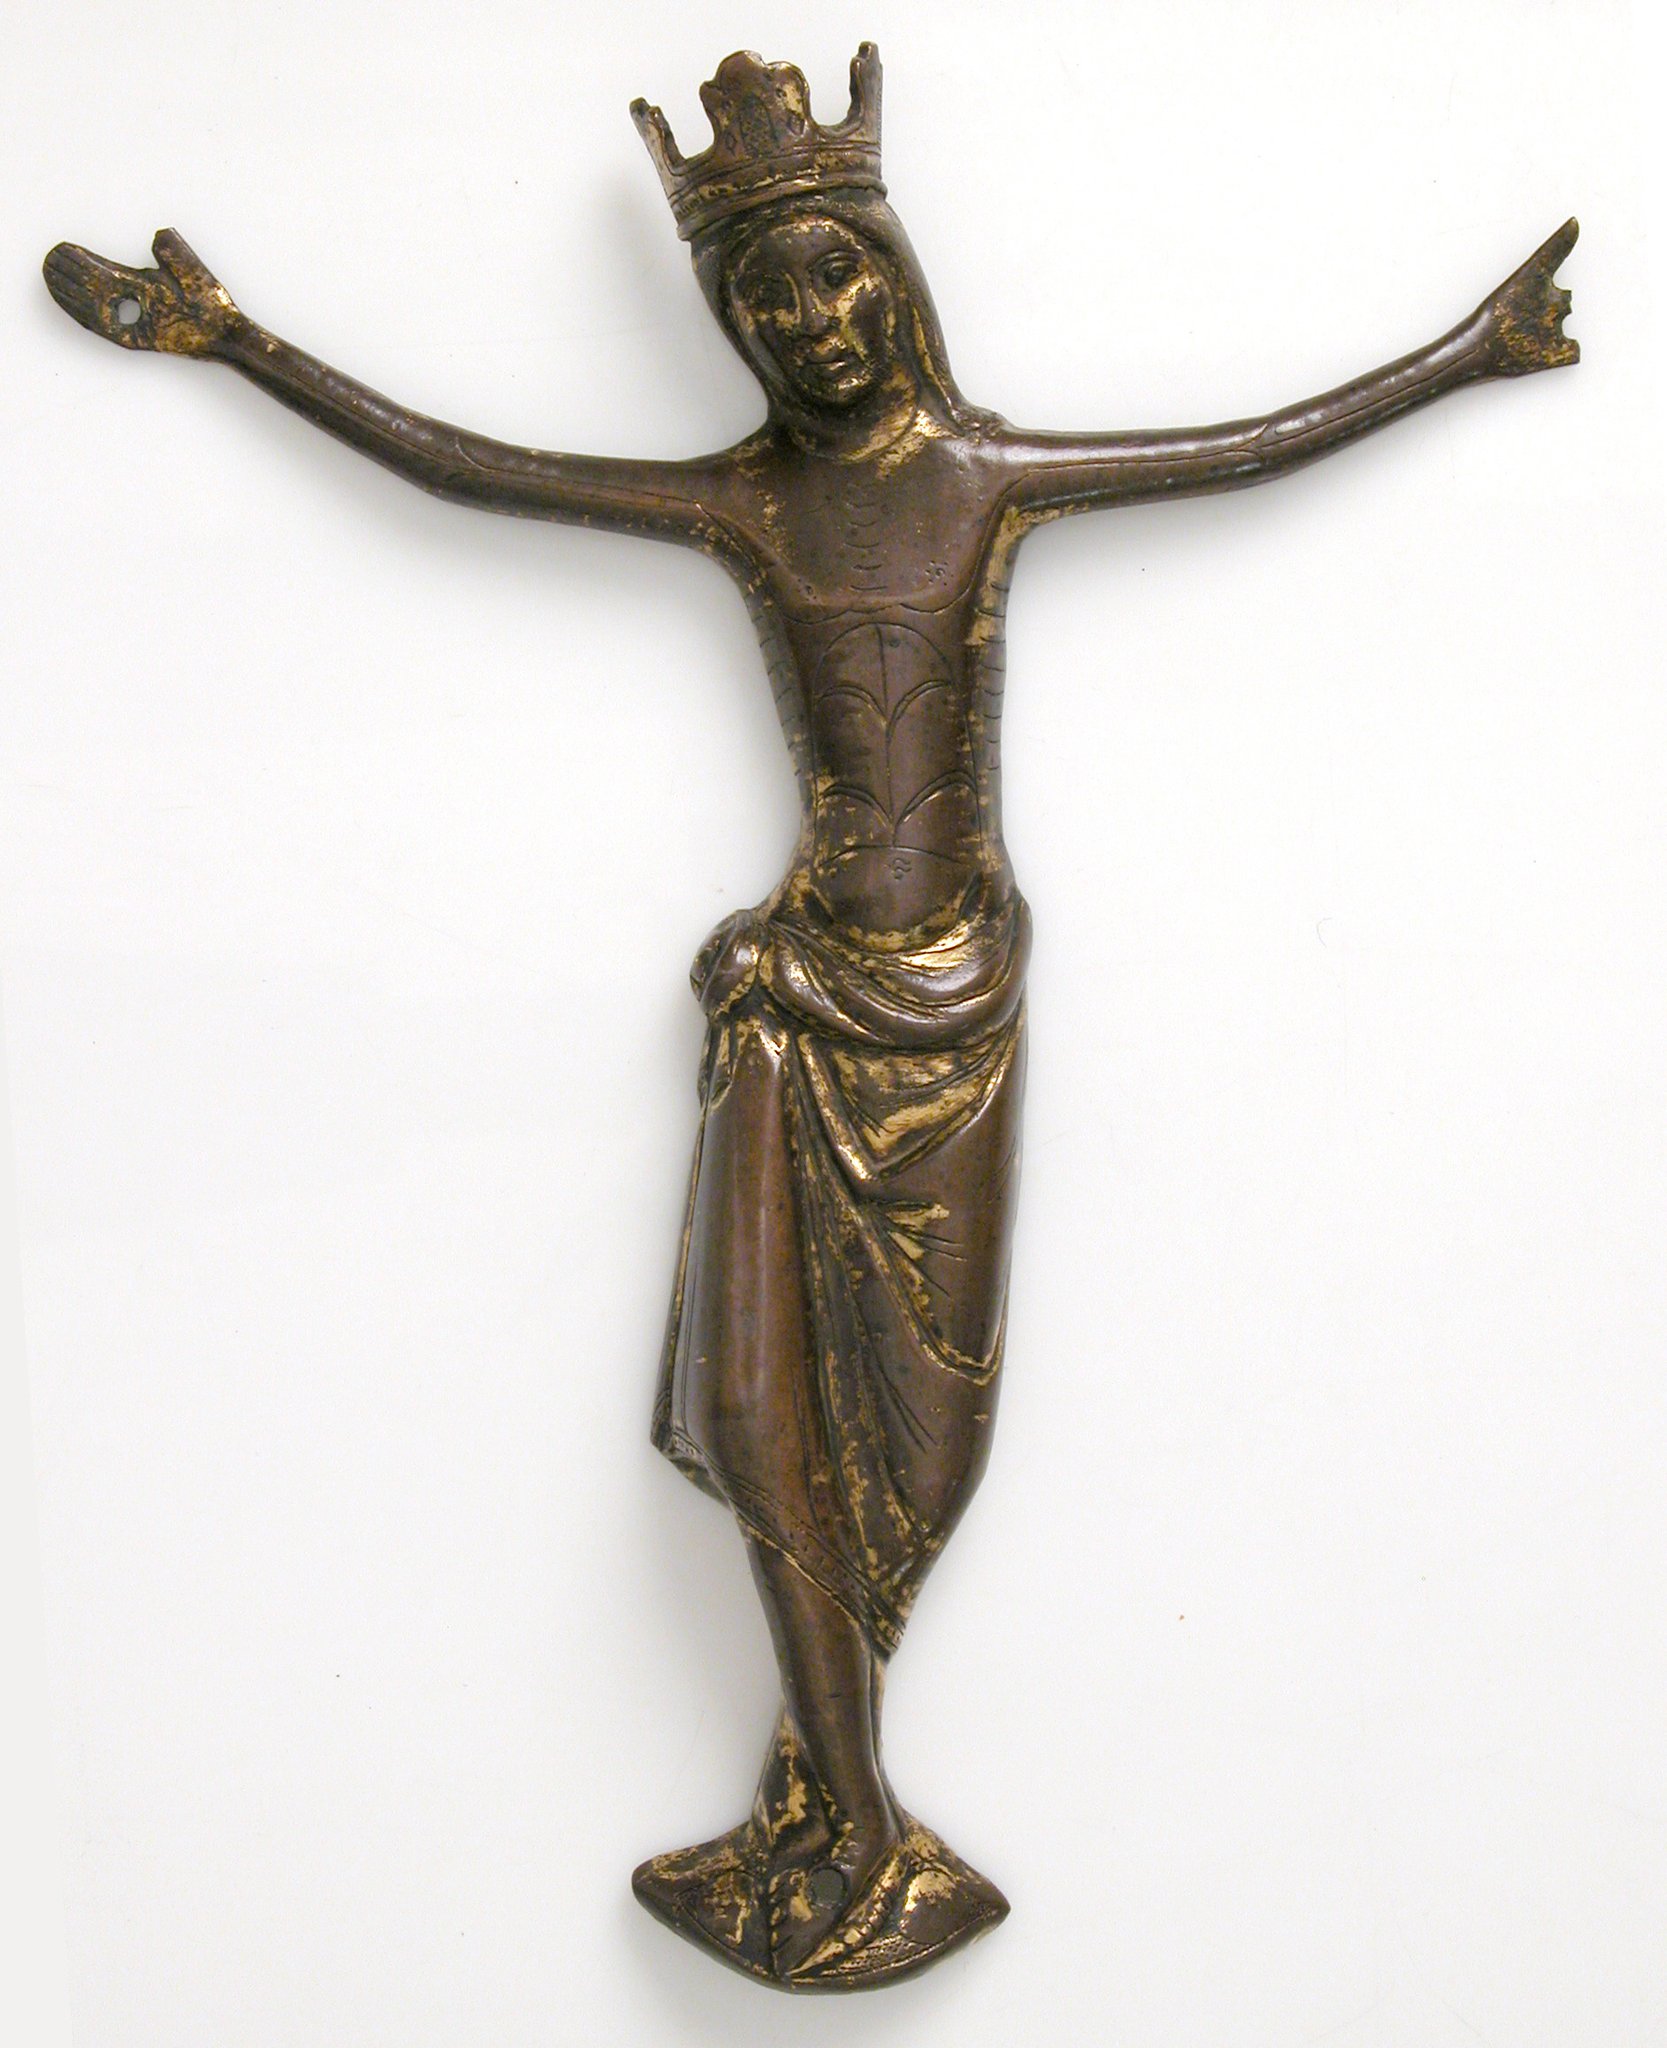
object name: corpus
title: Crucified Christ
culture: french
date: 1234-1266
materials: copper alloy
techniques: gilding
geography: france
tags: christ,crucifixion